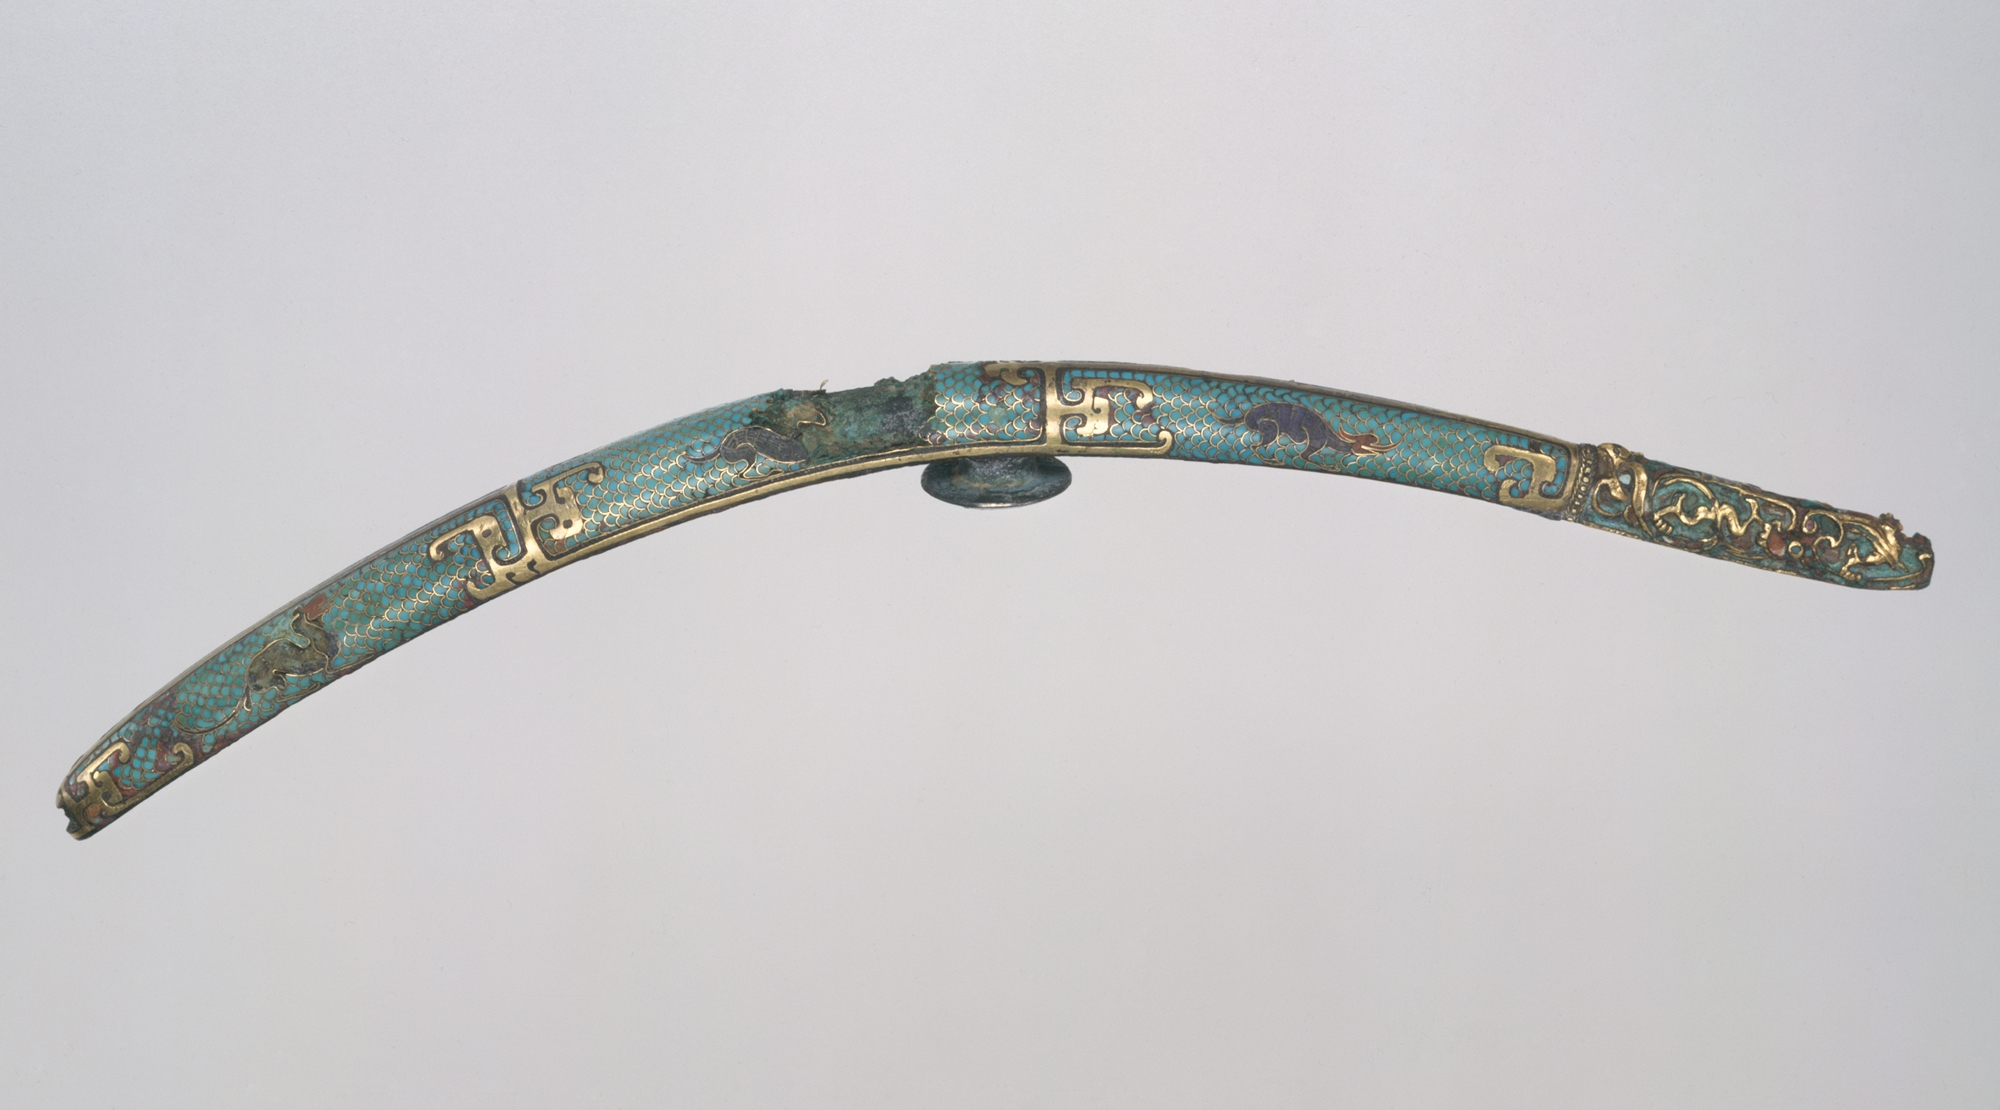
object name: belt hook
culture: chinese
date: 400-201 BCE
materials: bronze, gold, lapis lazuli, lead, silver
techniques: inlay